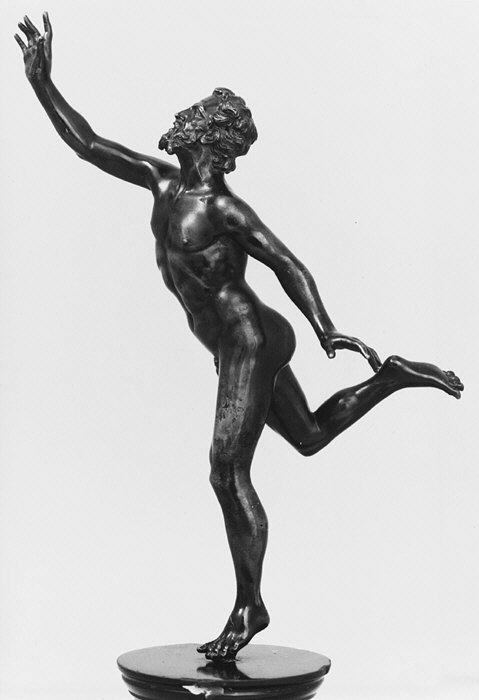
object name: statuette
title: Nude Male Runner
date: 1601-1800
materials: bronze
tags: male nudes,running